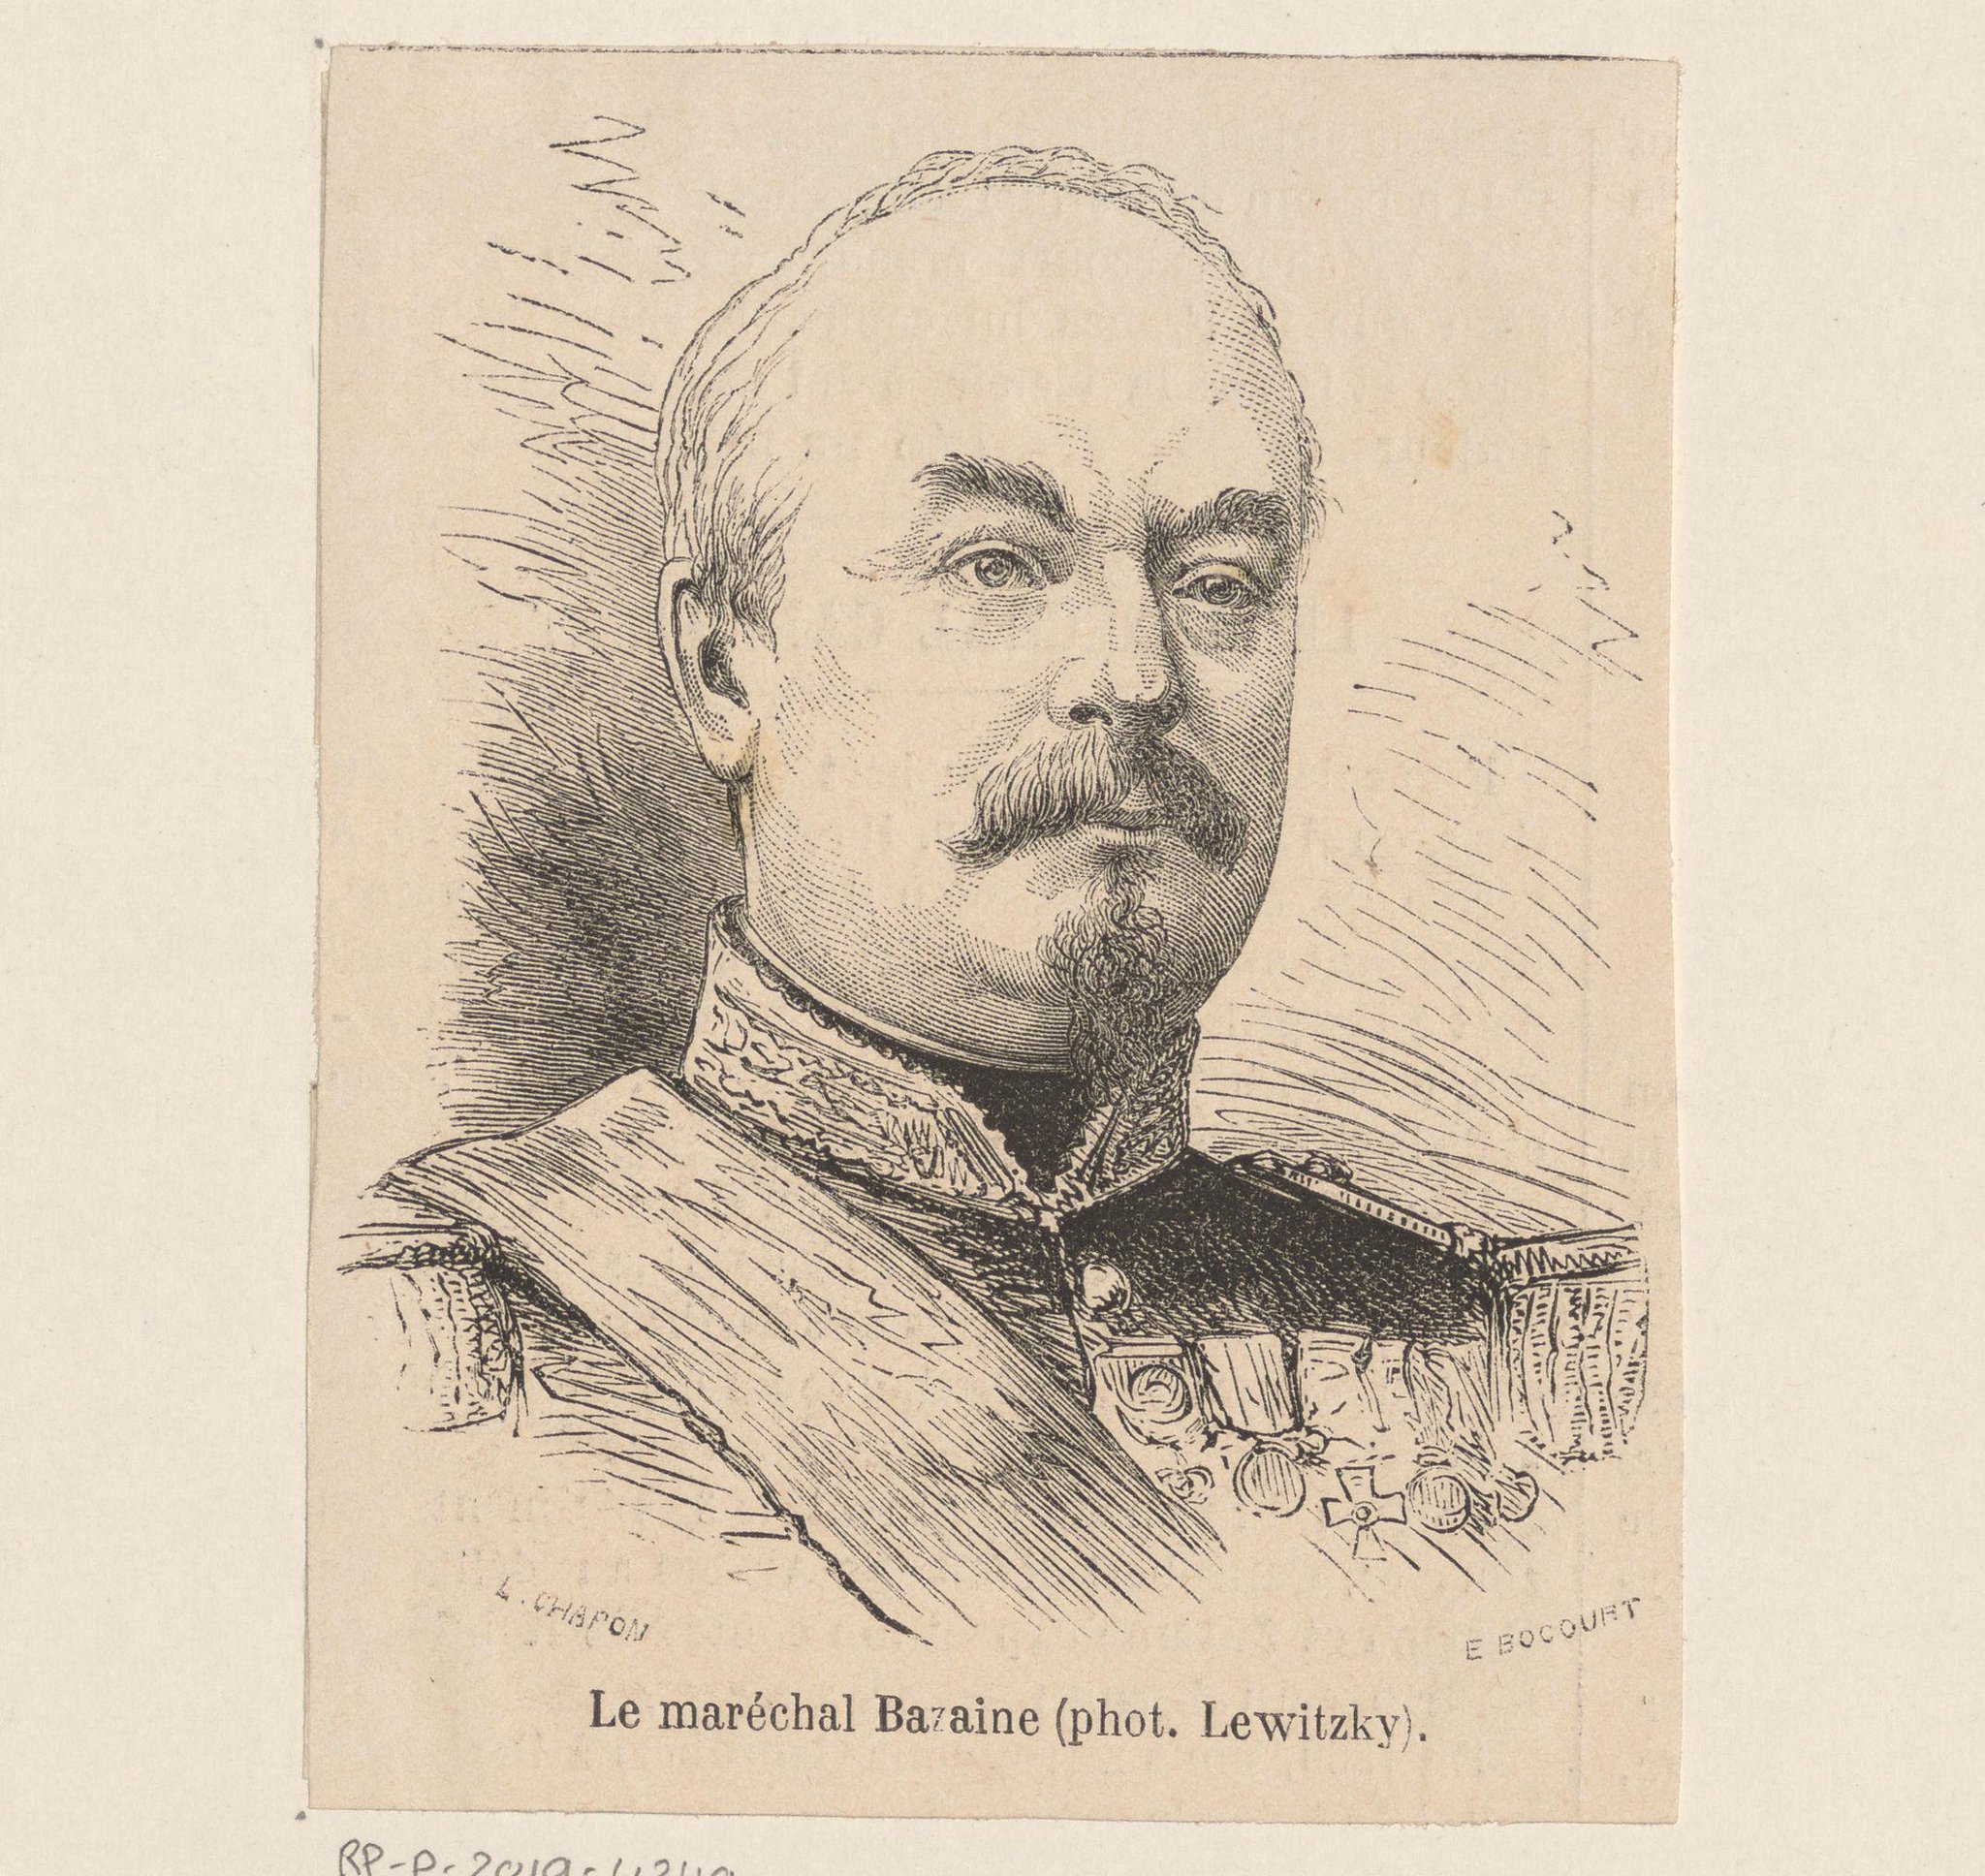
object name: book illustration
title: Portret van François Achille Bazaine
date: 1870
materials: paper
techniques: letterpress printing, engraving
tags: marseille, historical persons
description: Prent uit: Le monde illustré, journal hebdomdaire, nr. 693, 23 juli 1870.